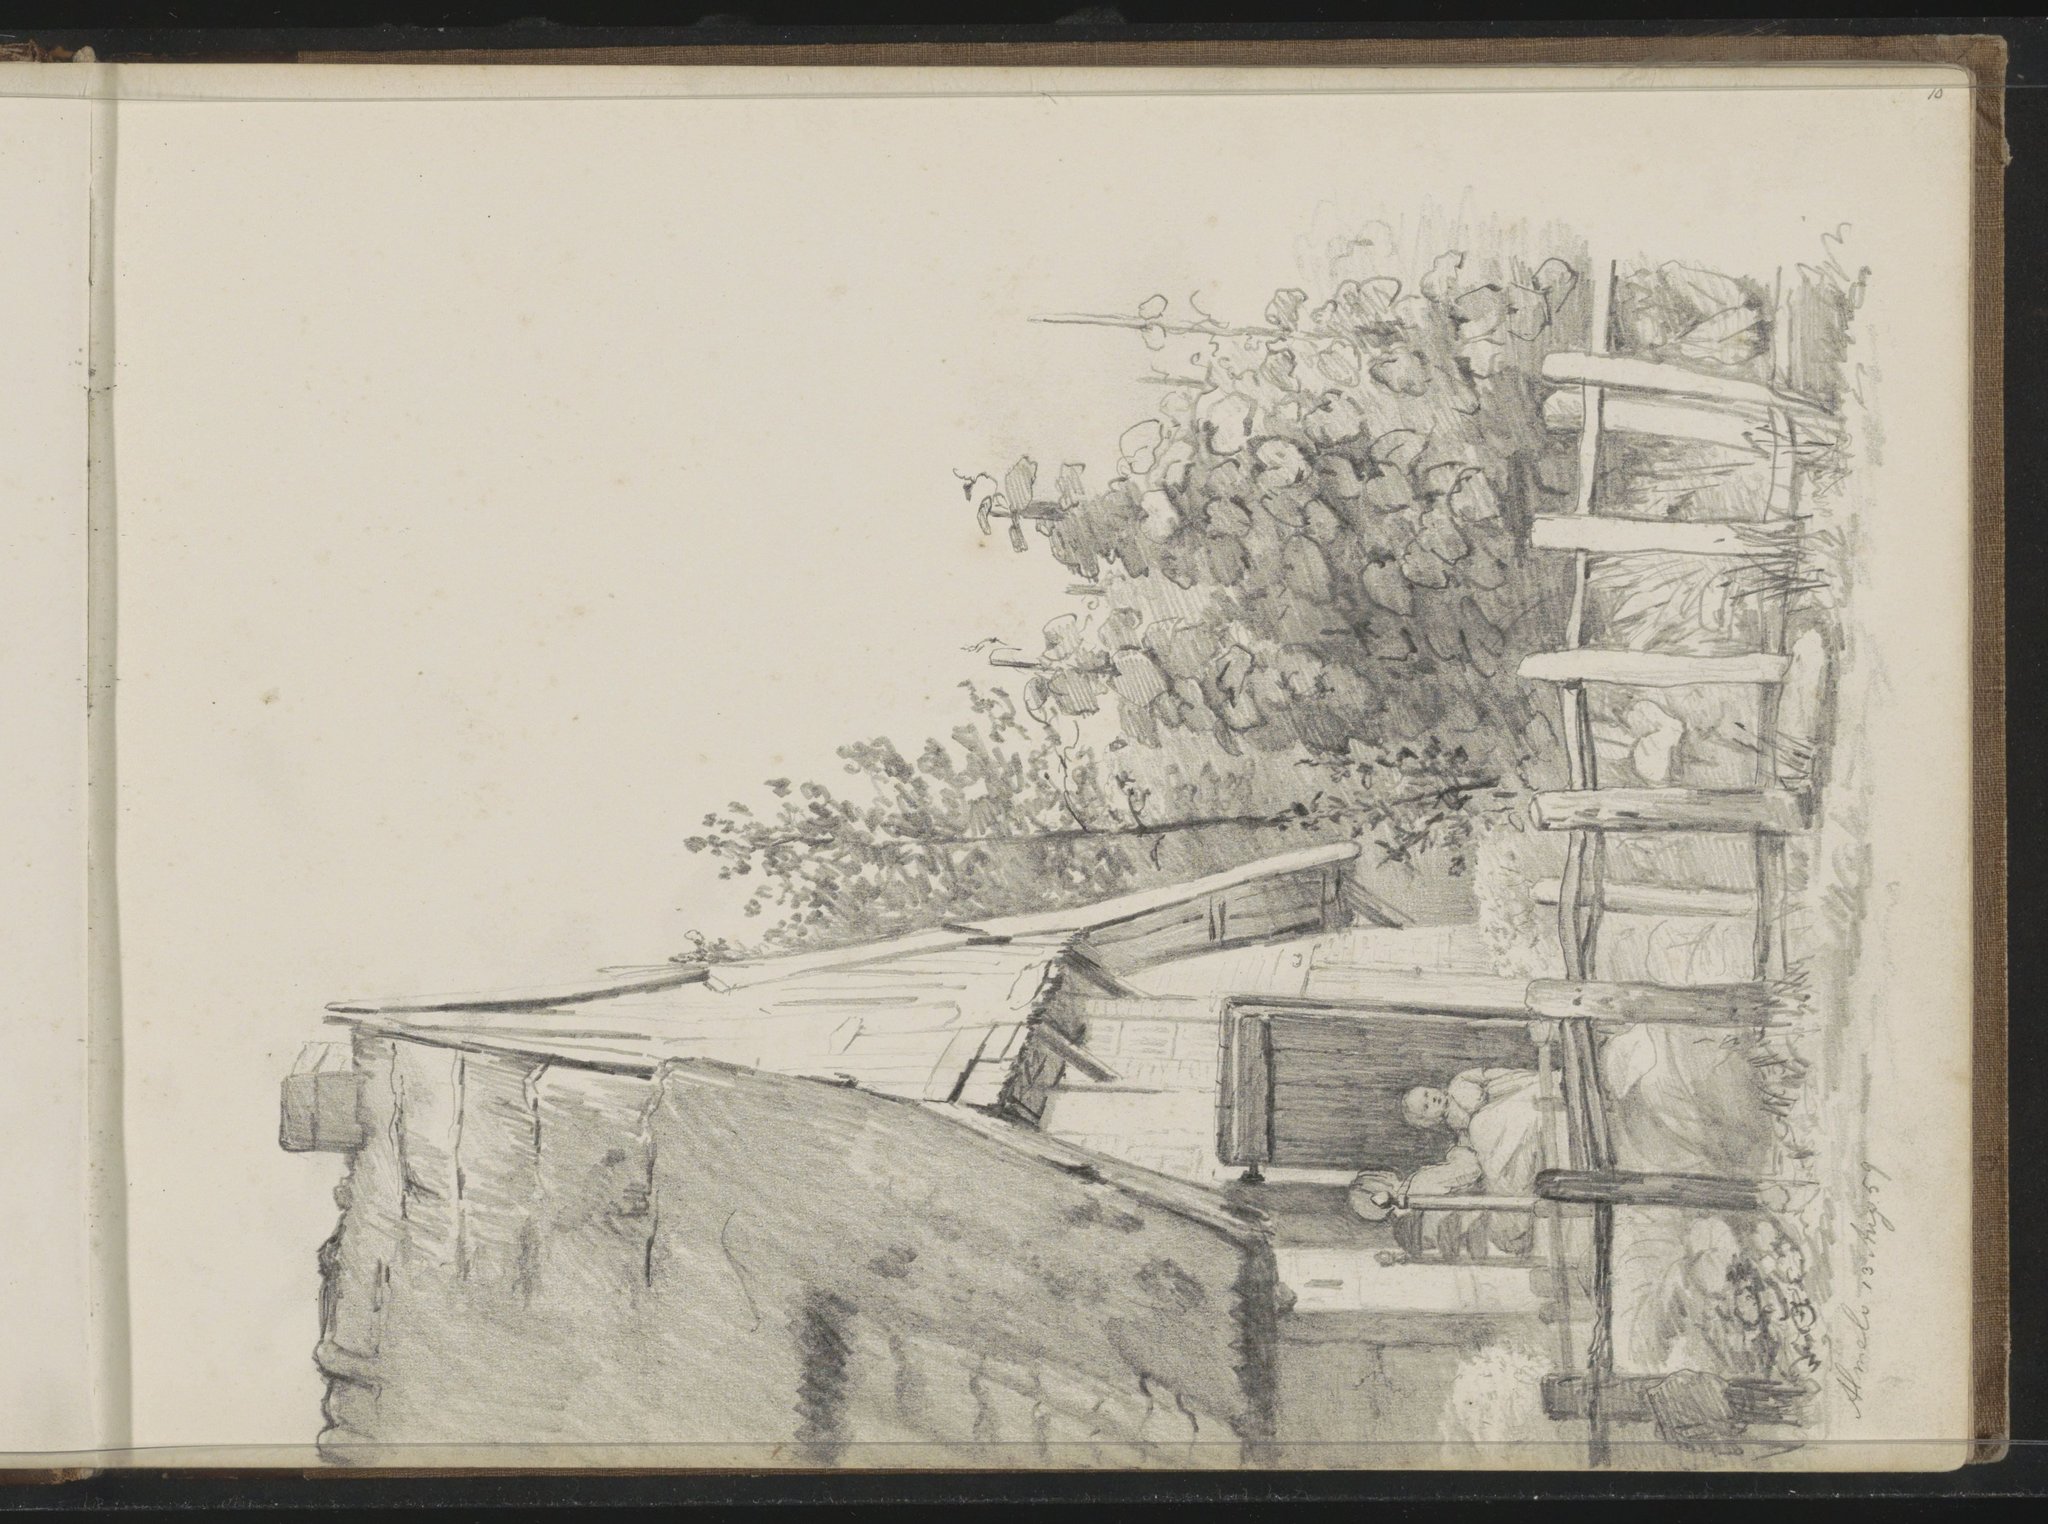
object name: sketchbook leaf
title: Moeder en kind voor een boerenwoning te Almelo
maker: hendrik valkenburg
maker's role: draughtsman, painter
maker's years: 1826-1896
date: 1808-1859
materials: paper, pencil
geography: almelo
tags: farmers - aa - female farmer, farmer's wife, cottage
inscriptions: date and inscription: ‘Almelo 13 Aug 59’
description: Blad 10 recto uit een schetsboek met 77 bladen.